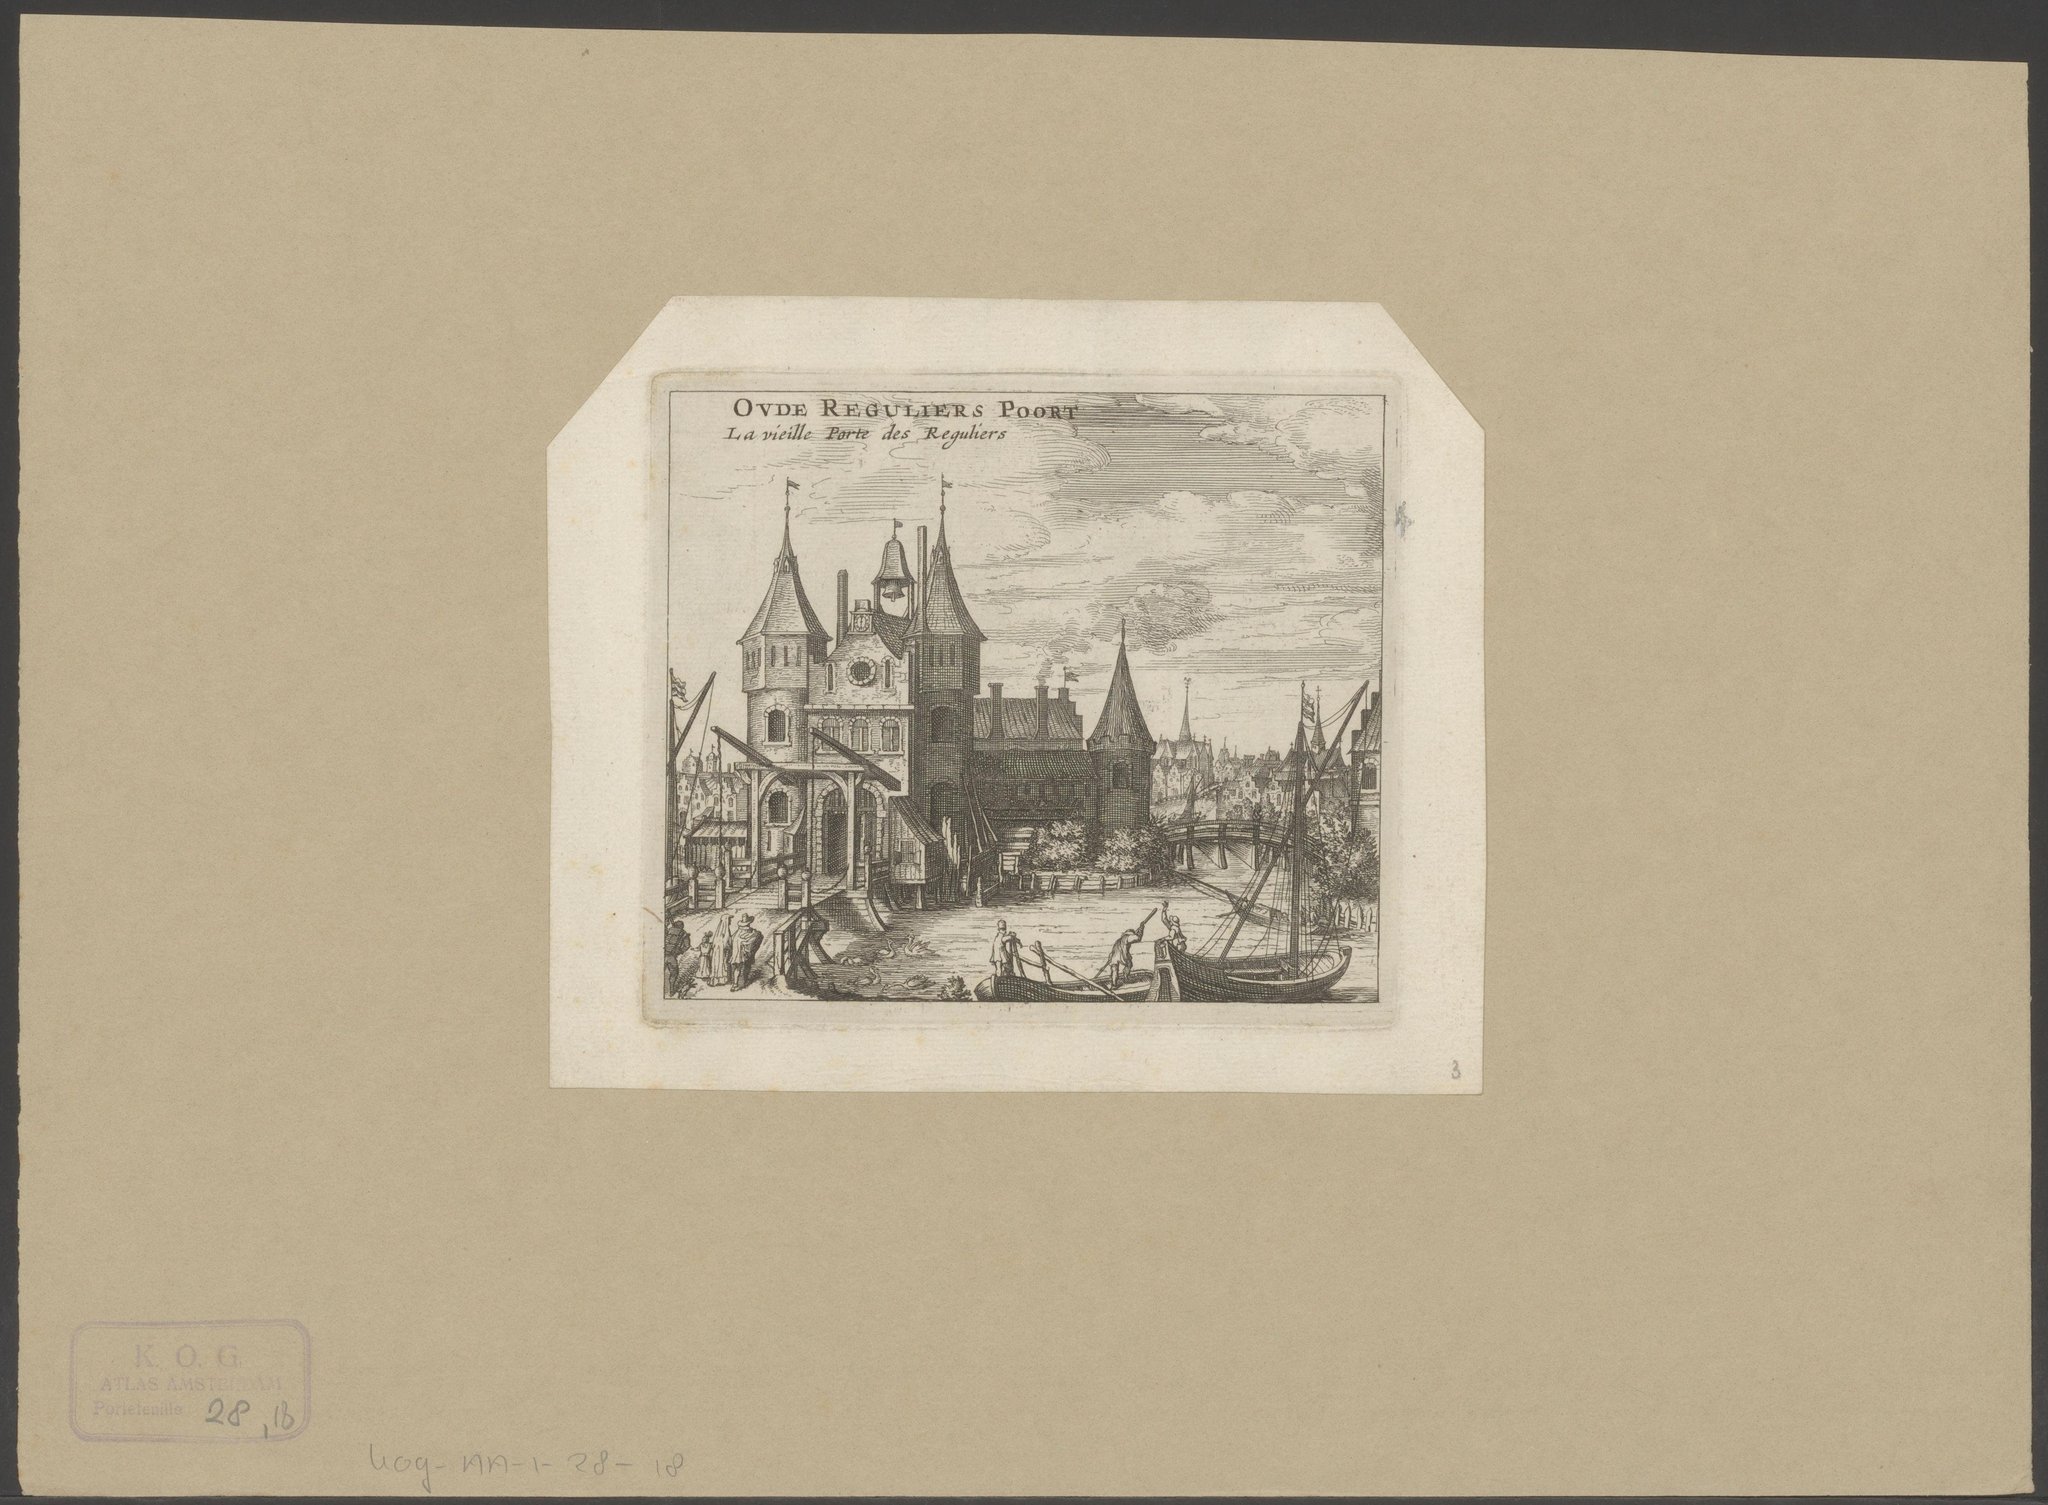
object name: print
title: Oude Reguliers Poort / La vieille Porte des Reguliers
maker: Anonymous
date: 1665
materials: paper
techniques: engraving, etching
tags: city-gate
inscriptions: collector's mark: Lugt 1641b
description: Prent met andere prent op verso gebruikt in: Beschryvinge van Amsterdam, haar eerste oorspronk uyt den Huyze der Heeren van Aemstel en Aemstellant (...). Amsterdam: Marcus Willemsz. Doornick, 1665.